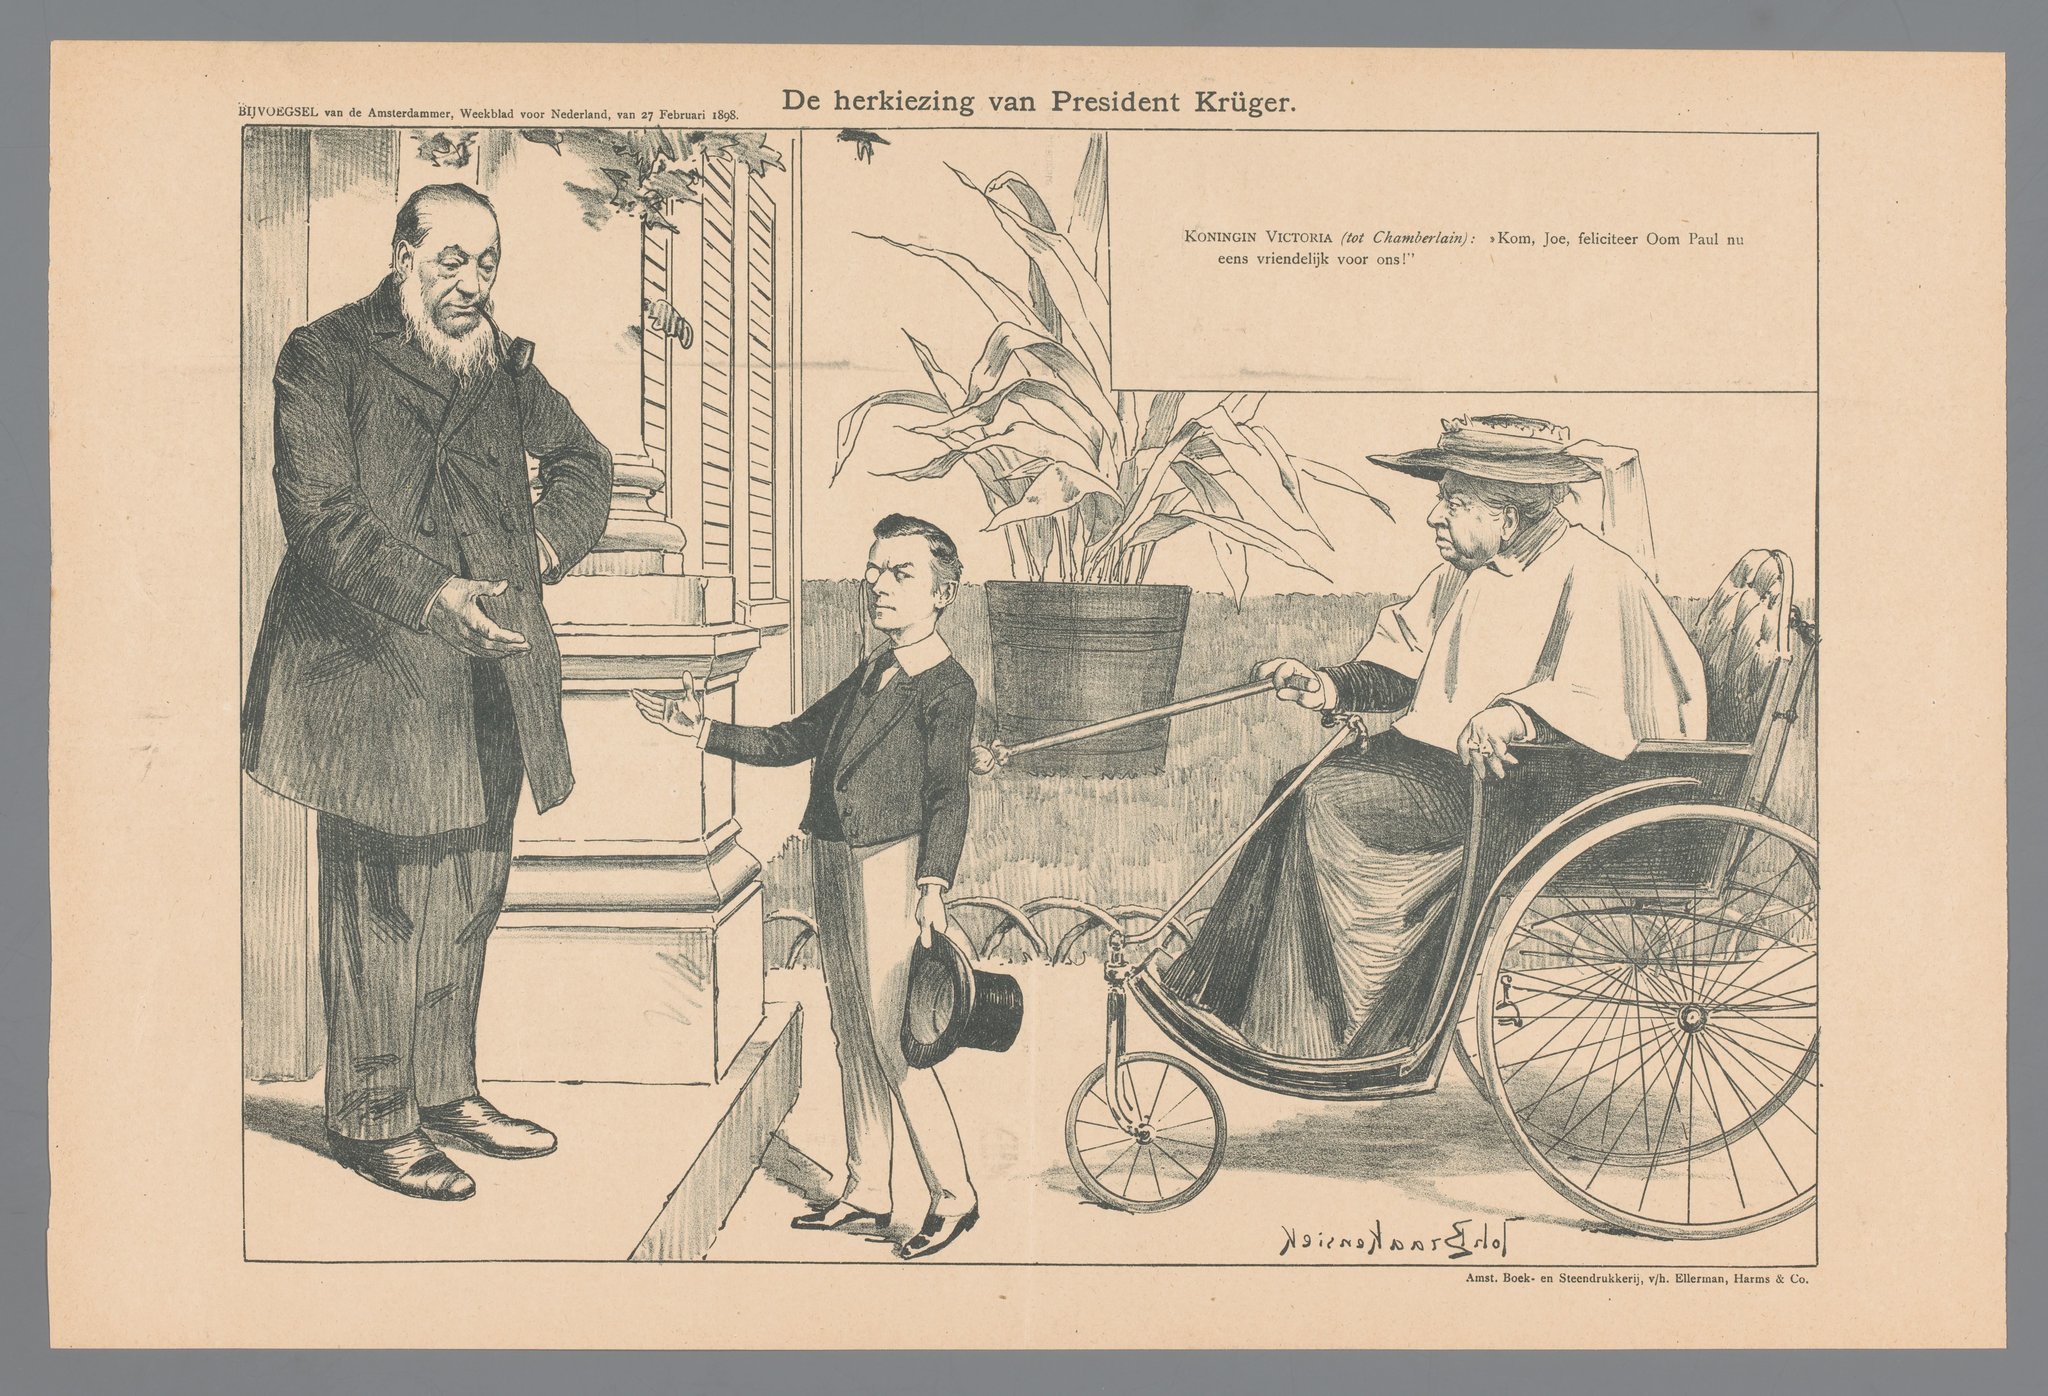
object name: cartoon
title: De herkiezing van President Krüger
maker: johan braakensiek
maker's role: draughtsman, print maker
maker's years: 1858-1940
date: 1898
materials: paper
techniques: lithograph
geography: amsterdam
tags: victoria (koningin van het verenigd koninkrijk en keizerin van india), politician, historical persons, political caricatures and satires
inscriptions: date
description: Prent uit het bijvoegsel van: De Amsterdammer. Weekblad voor Nederland, 27 februari 1898.